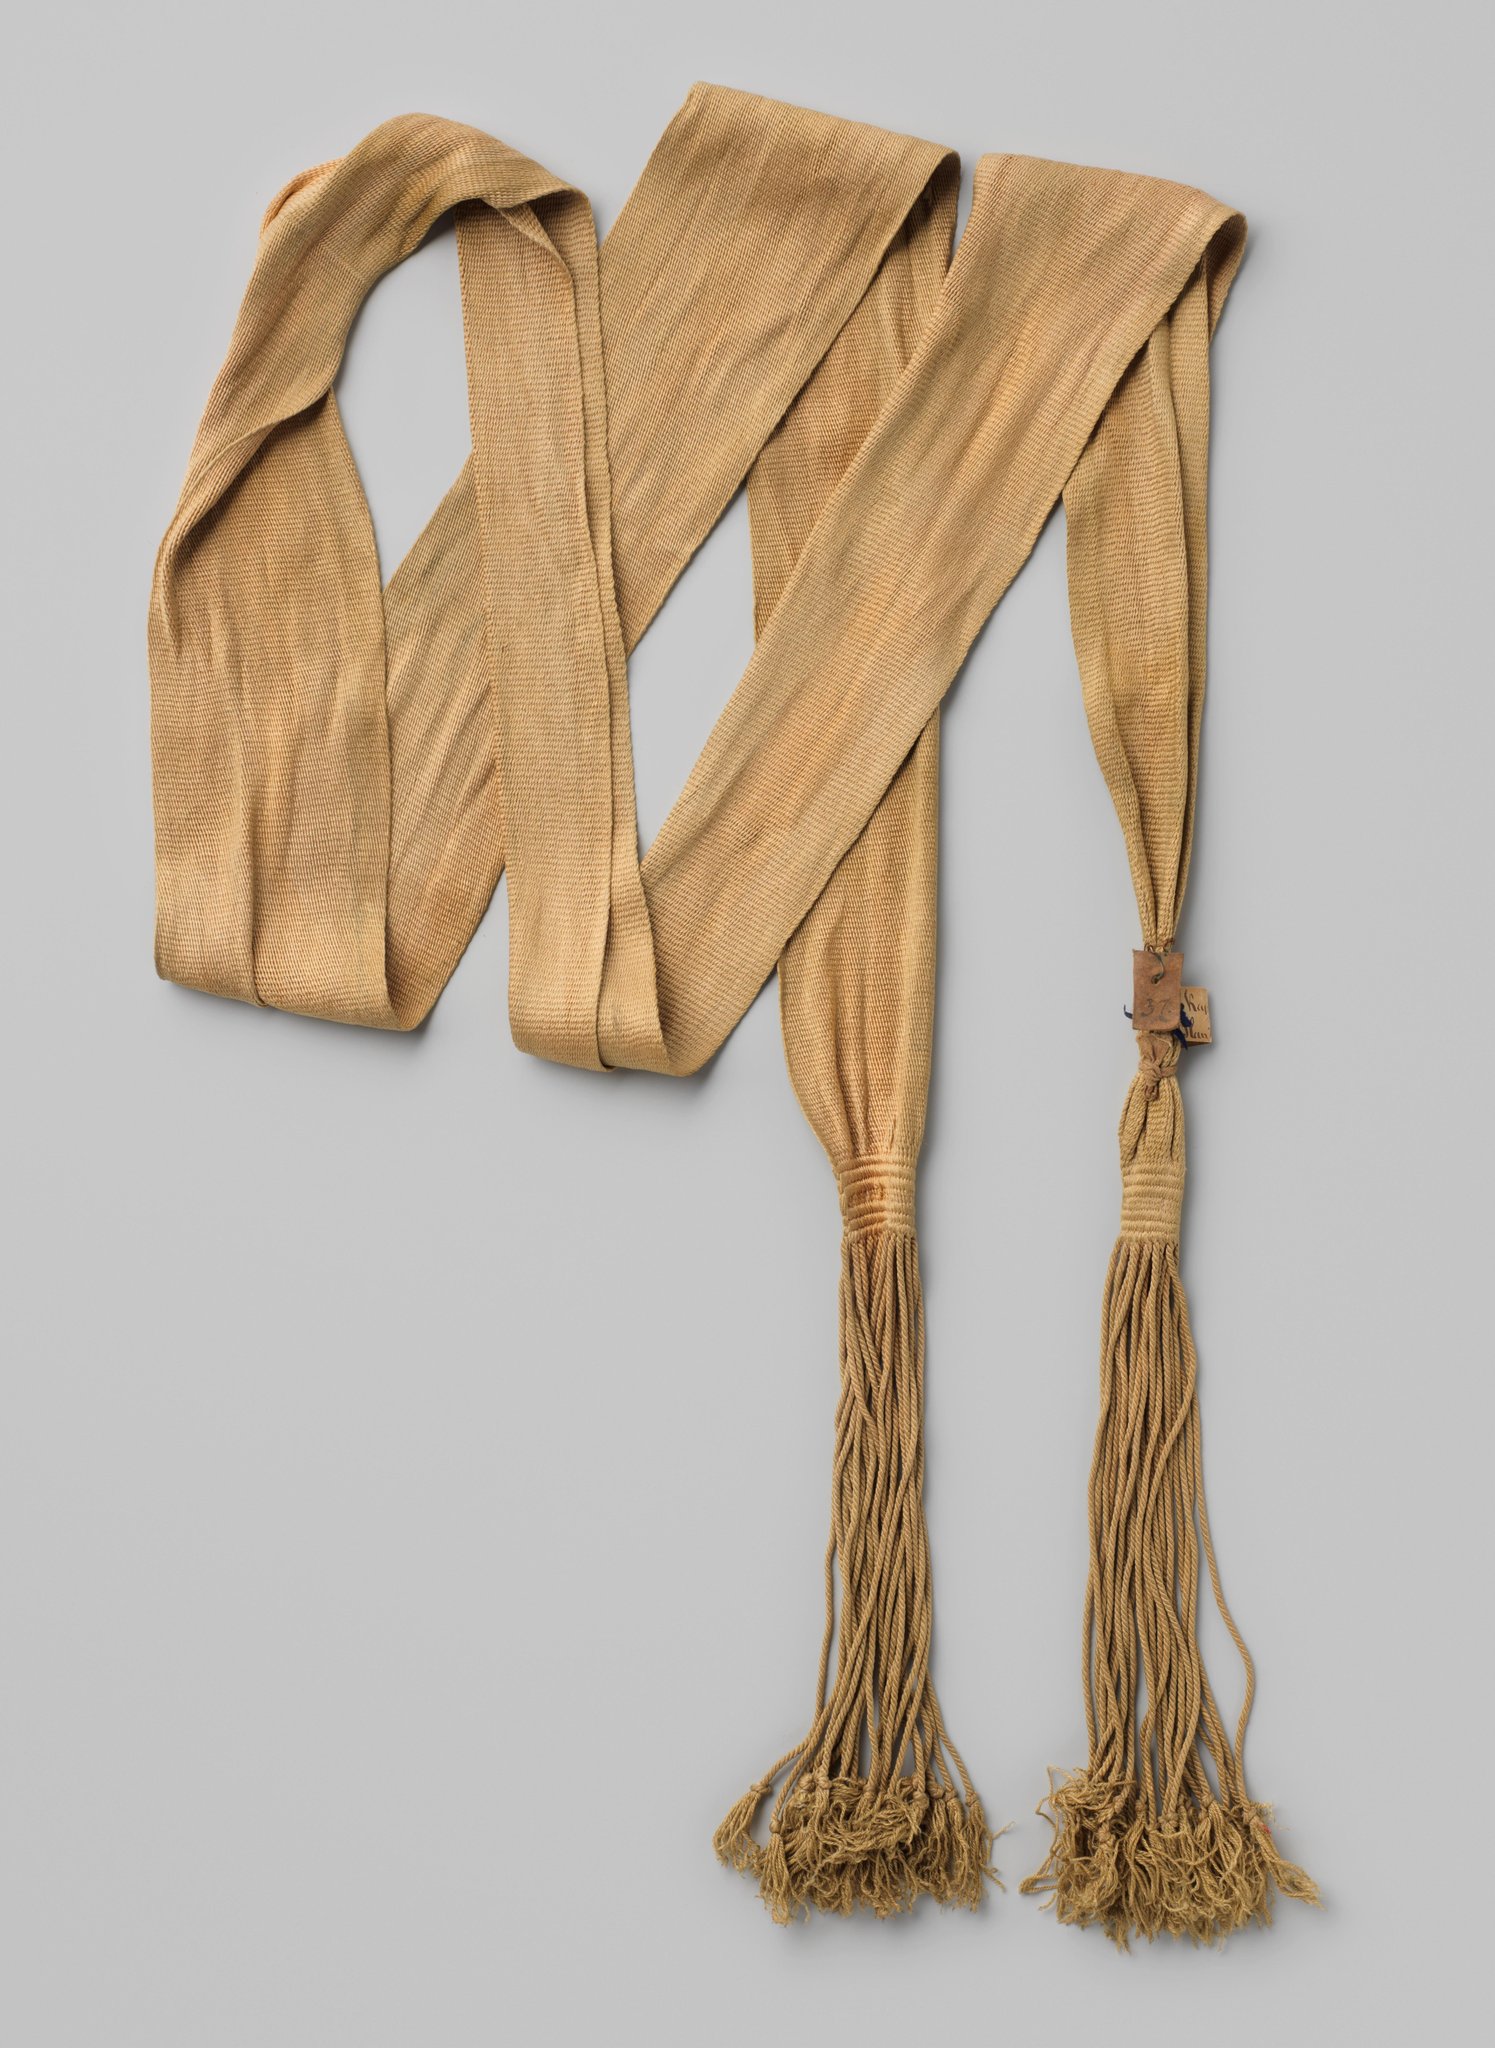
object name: sash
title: Sjerp gedragen door kapitein Blankenheim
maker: Anonymous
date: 1800-1830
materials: silk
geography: netherlands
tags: blankenheim